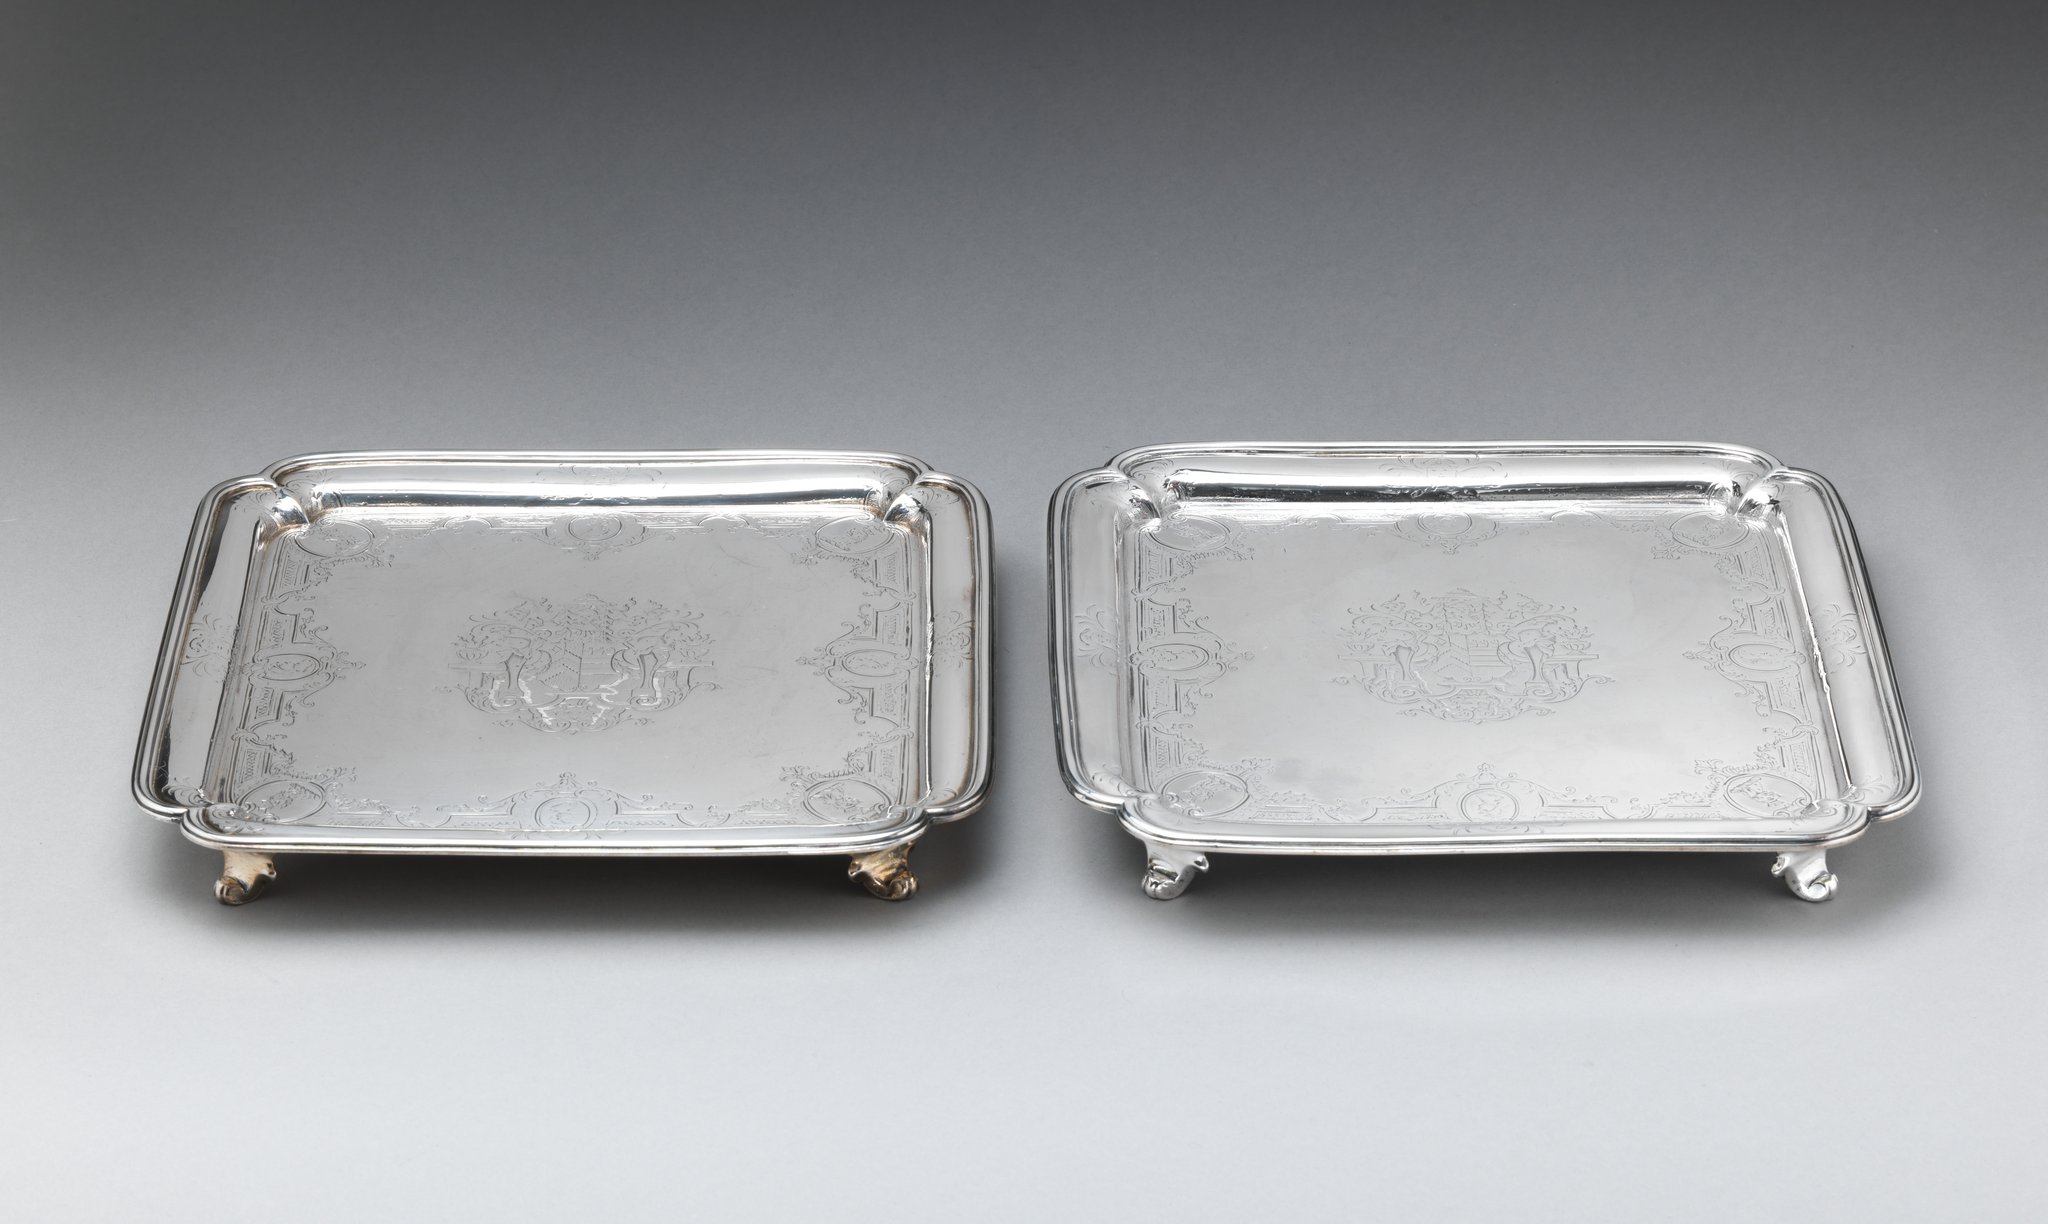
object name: salver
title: Salver (one of a pair)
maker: paul de lamerie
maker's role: maker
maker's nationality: british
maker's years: 1688-1751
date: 1730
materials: silver